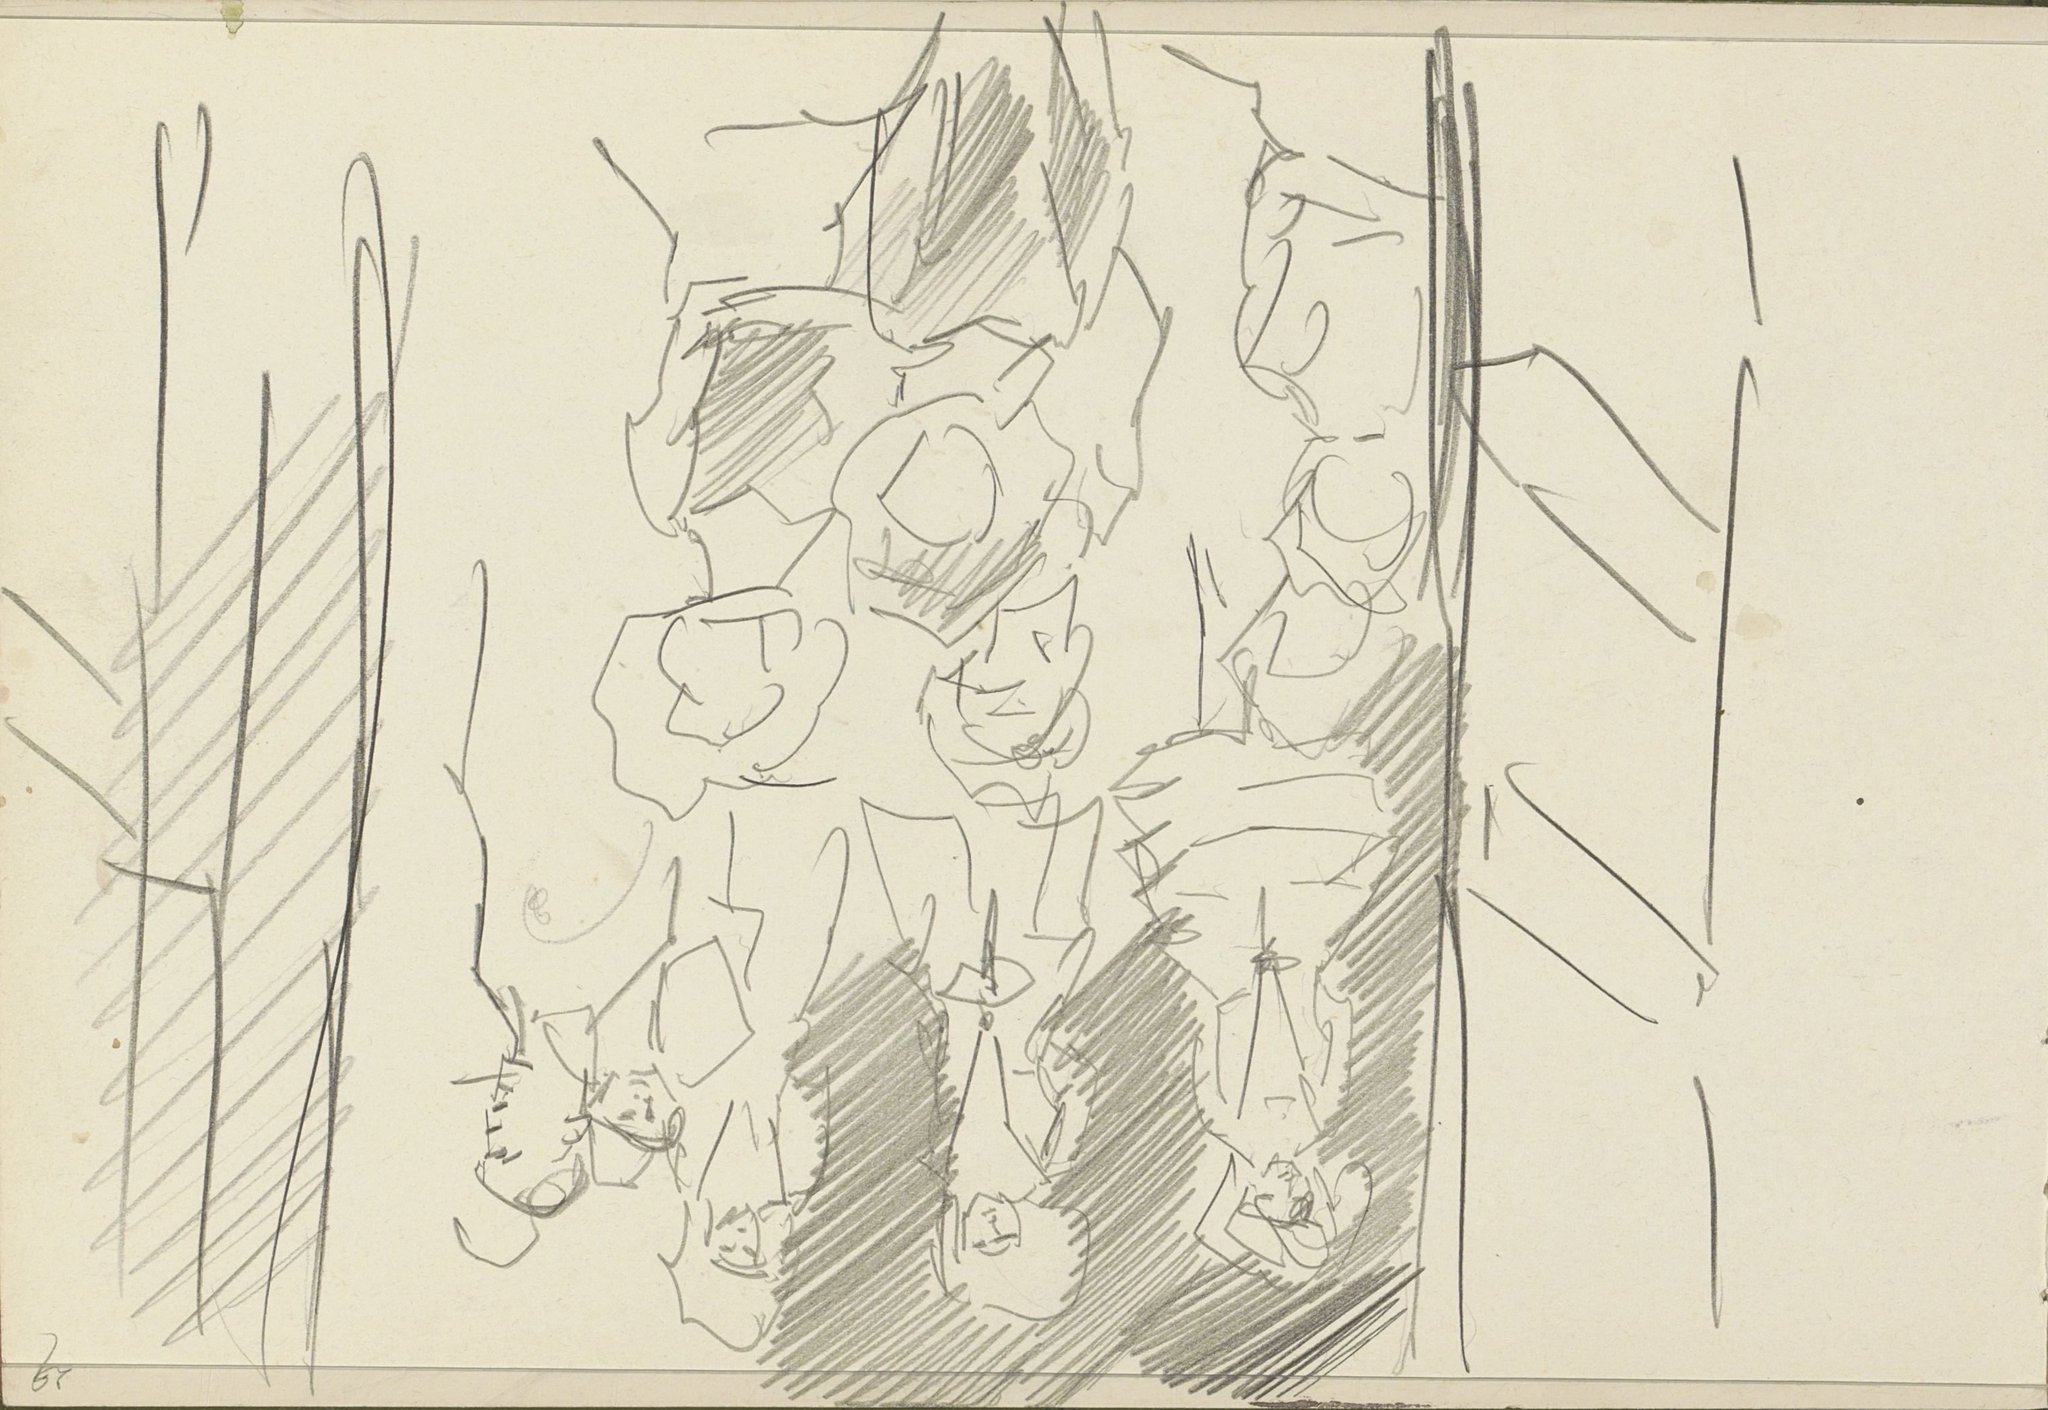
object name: sketchbook leaf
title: Figuren, mogelijk op het toneel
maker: isaac israels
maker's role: draughtsman, painter, print maker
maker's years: 1865-1934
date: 1875-1934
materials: paper, pencil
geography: the hague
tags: theatre, theatrical performance, the stage and its equipment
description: Blad 6 verso uit schetsboek XXVIII met 17 bladen.